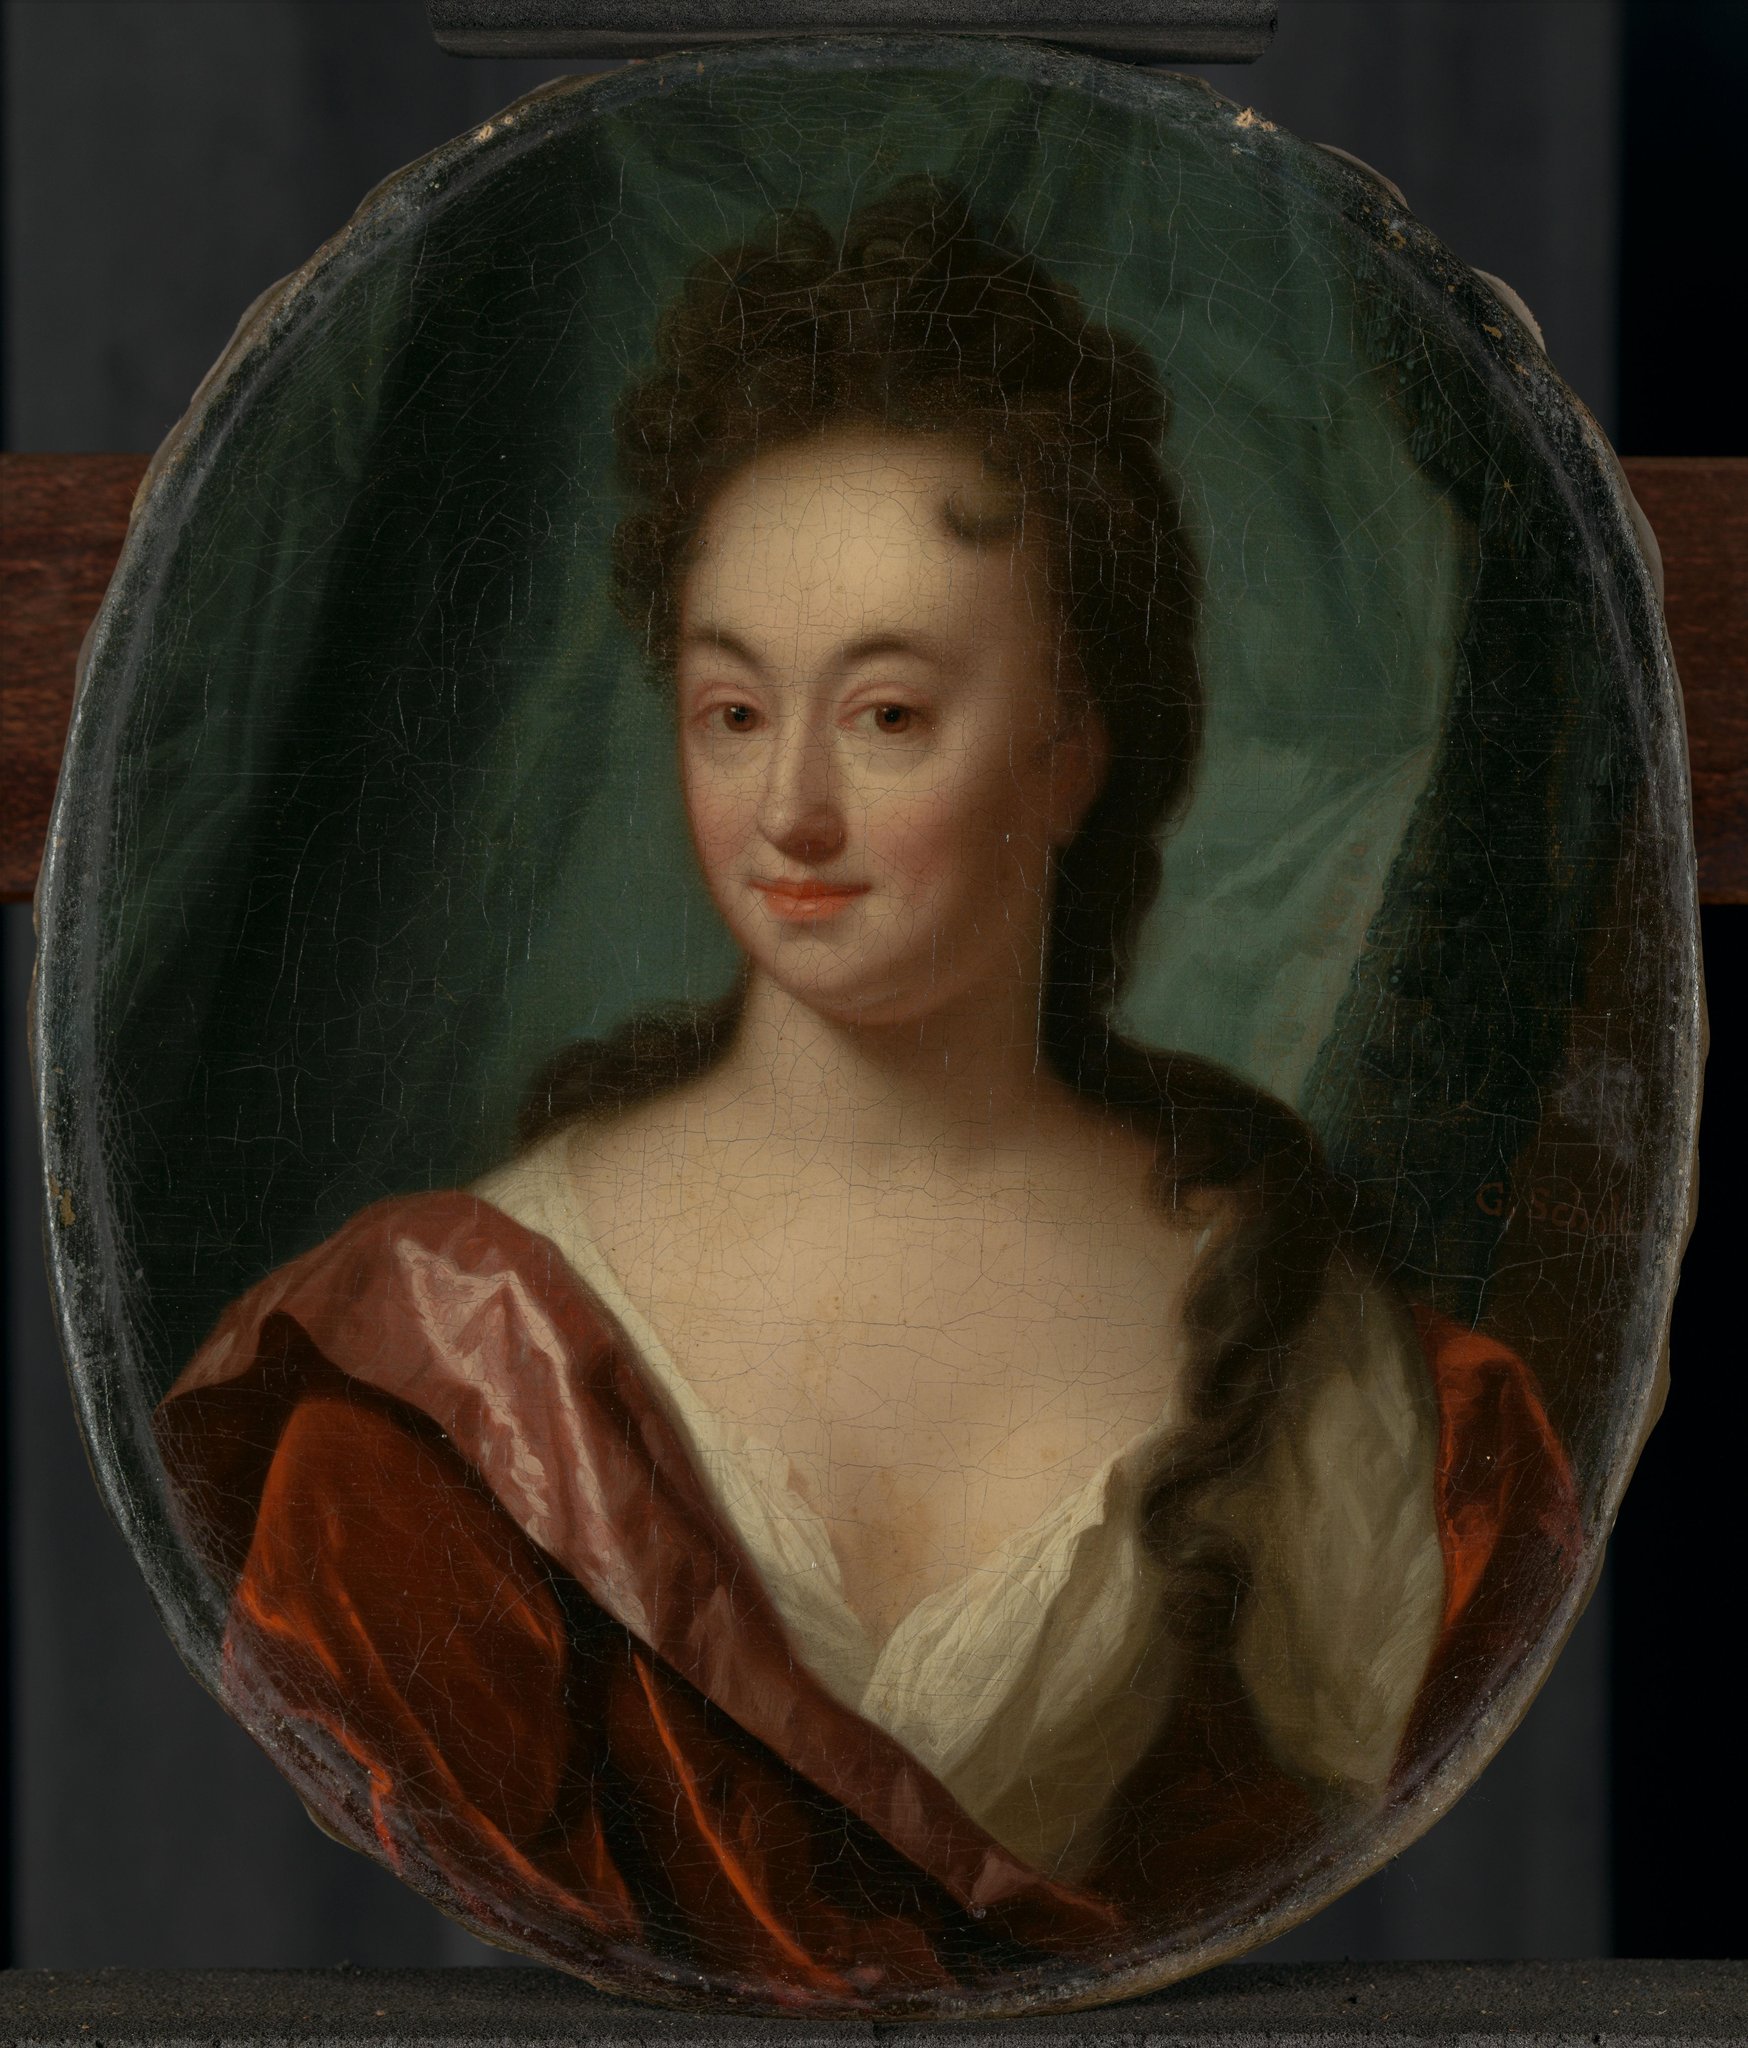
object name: painting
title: Portrait of Anna Maria Gool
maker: godfried schalcken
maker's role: draughtsman, painter, print maker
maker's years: 1643-1706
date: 1699-1706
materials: canvas, oil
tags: historical persons - bb - woman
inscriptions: signature: ‘G. Schalcken’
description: Portret van mejuffrouw van Gool, gezelschapsdame van Josina Clara van Citters. Buste, en face, in ovaal.